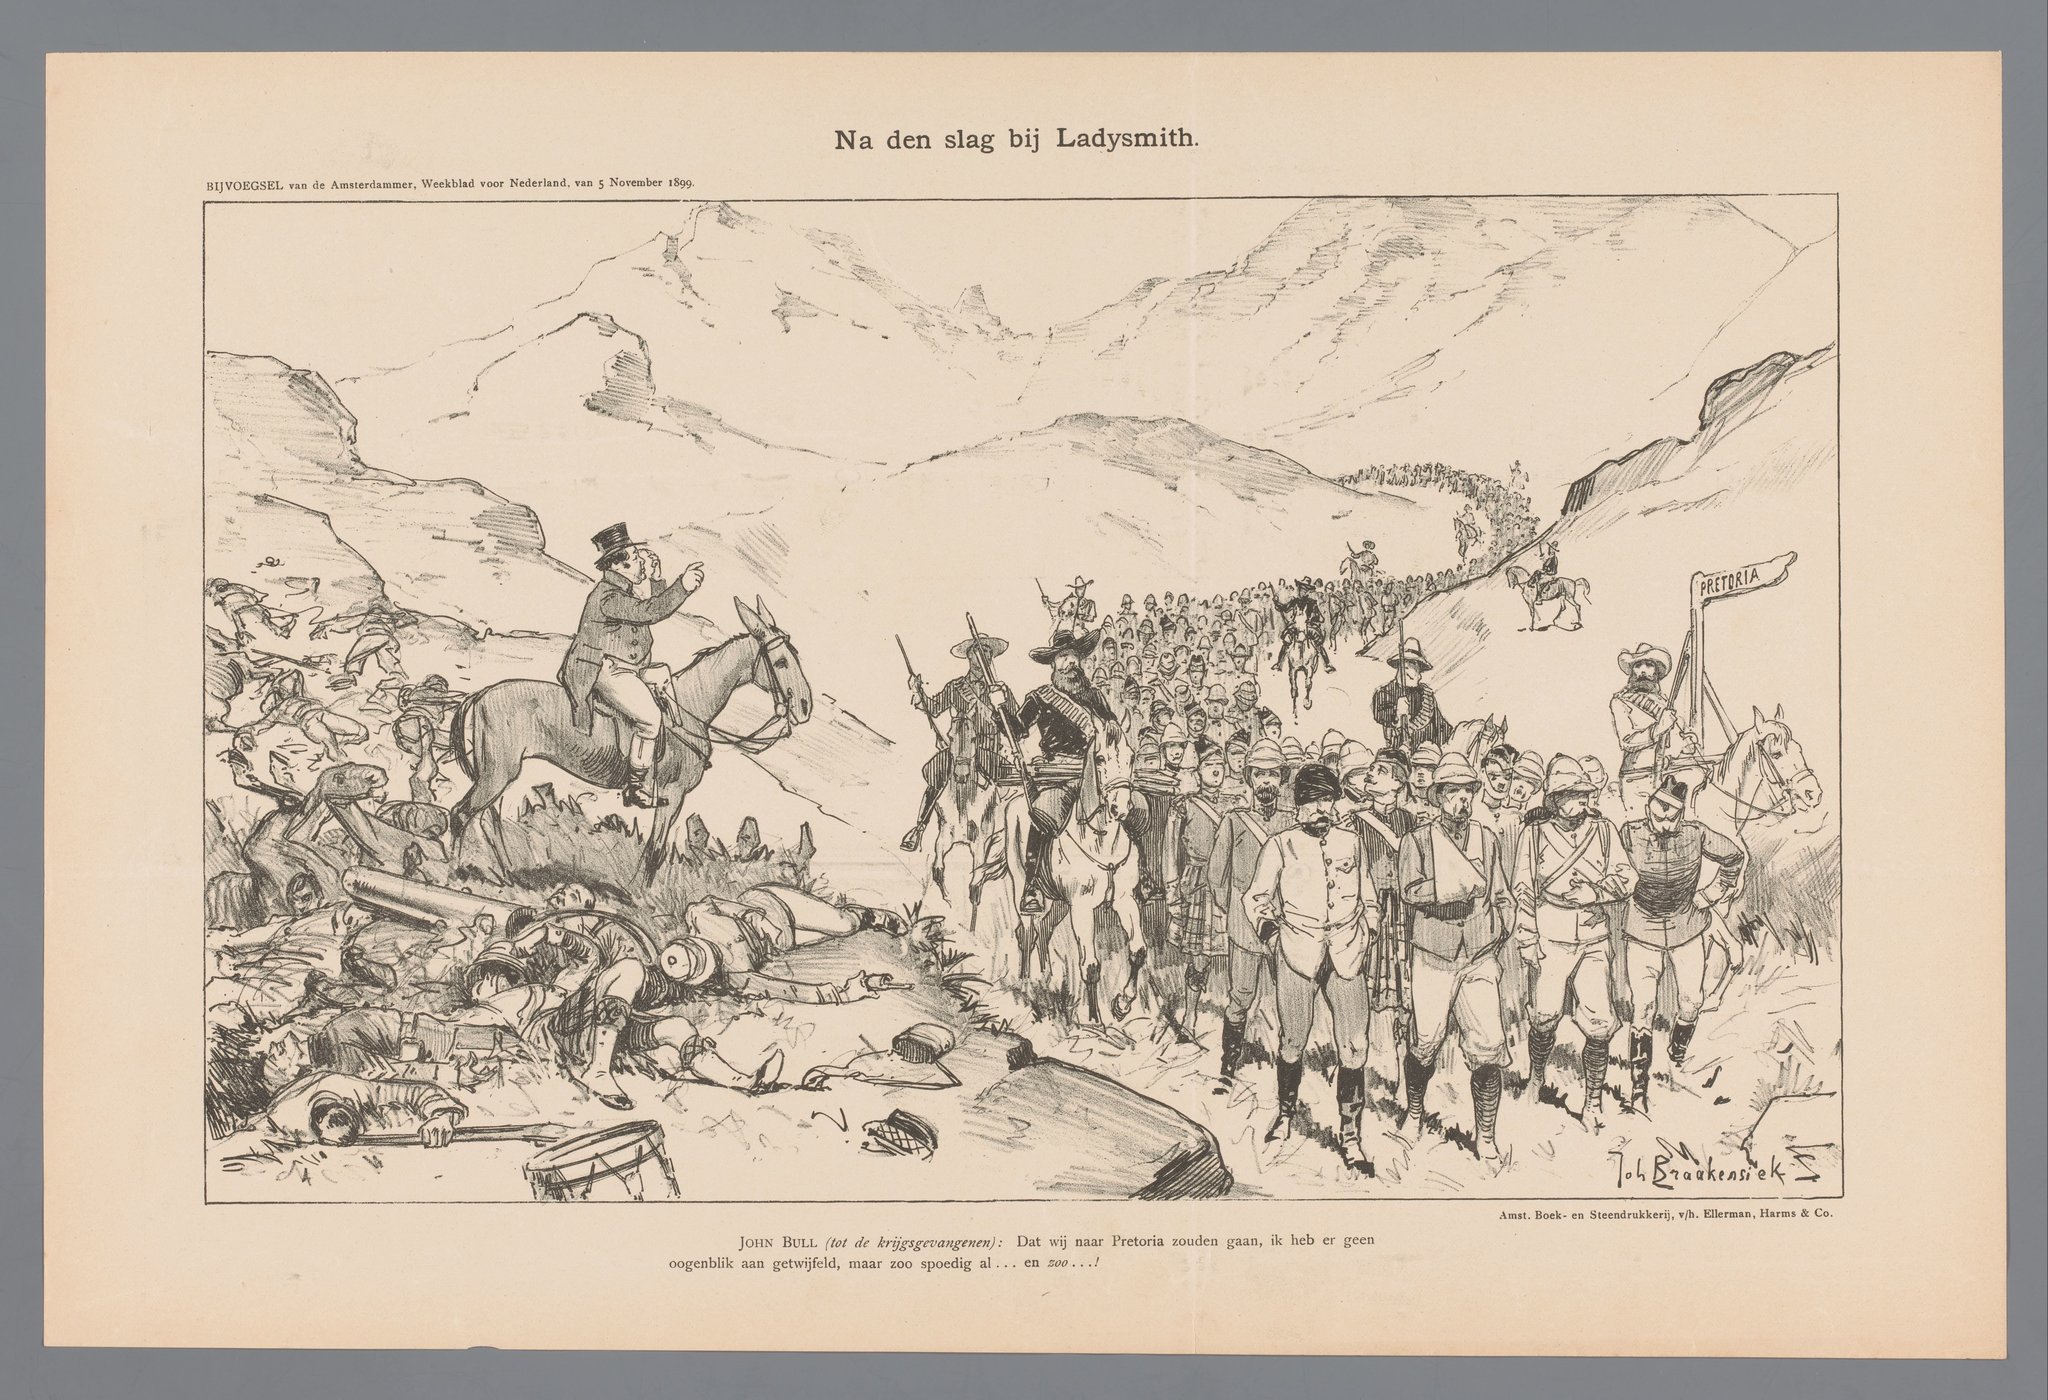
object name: cartoon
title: Na den slag bij Ladysmith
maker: johan braakensiek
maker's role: draughtsman, print maker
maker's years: 1858-1940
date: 1899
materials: paper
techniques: lithograph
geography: amsterdam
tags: personifications of countries, nations, states, districts, etc., prisoner of war (after the battle), political caricatures and satires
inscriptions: date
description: Prent uit het bijvoegsel van: De Amsterdammer. Weekblad voor Nederland, 5 november 1899.